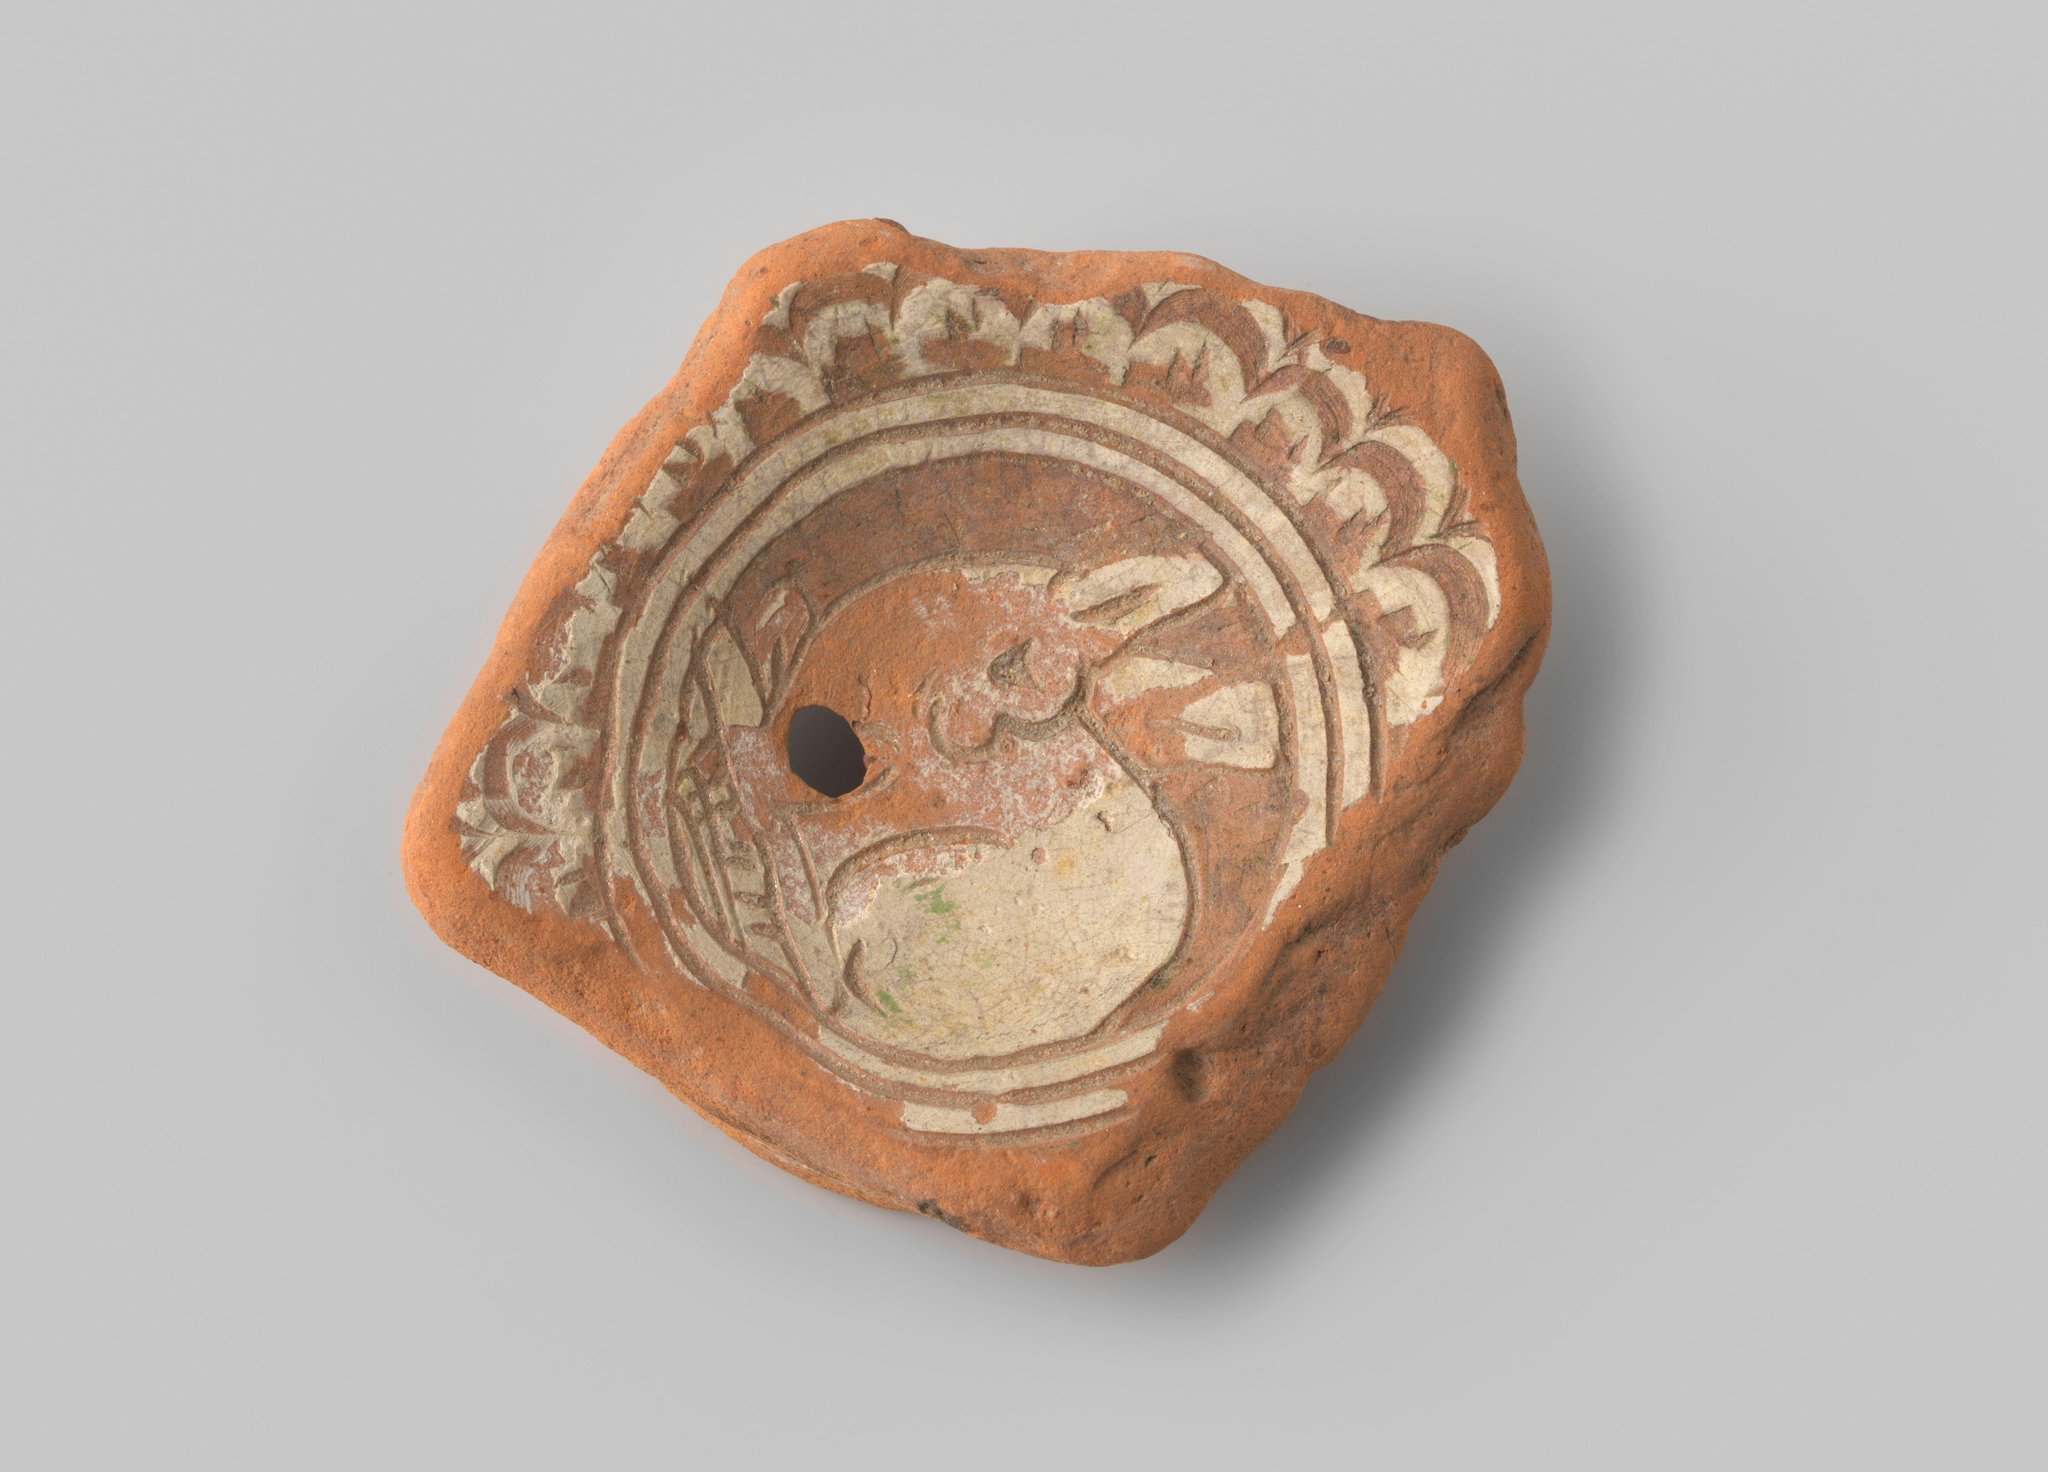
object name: sherd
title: Fragment (voet) met rode scherf, aan de binnenkant in dubbele cirkel in witte slib een zittend konijntje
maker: Anonymous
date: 1200-1899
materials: earthenware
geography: italy